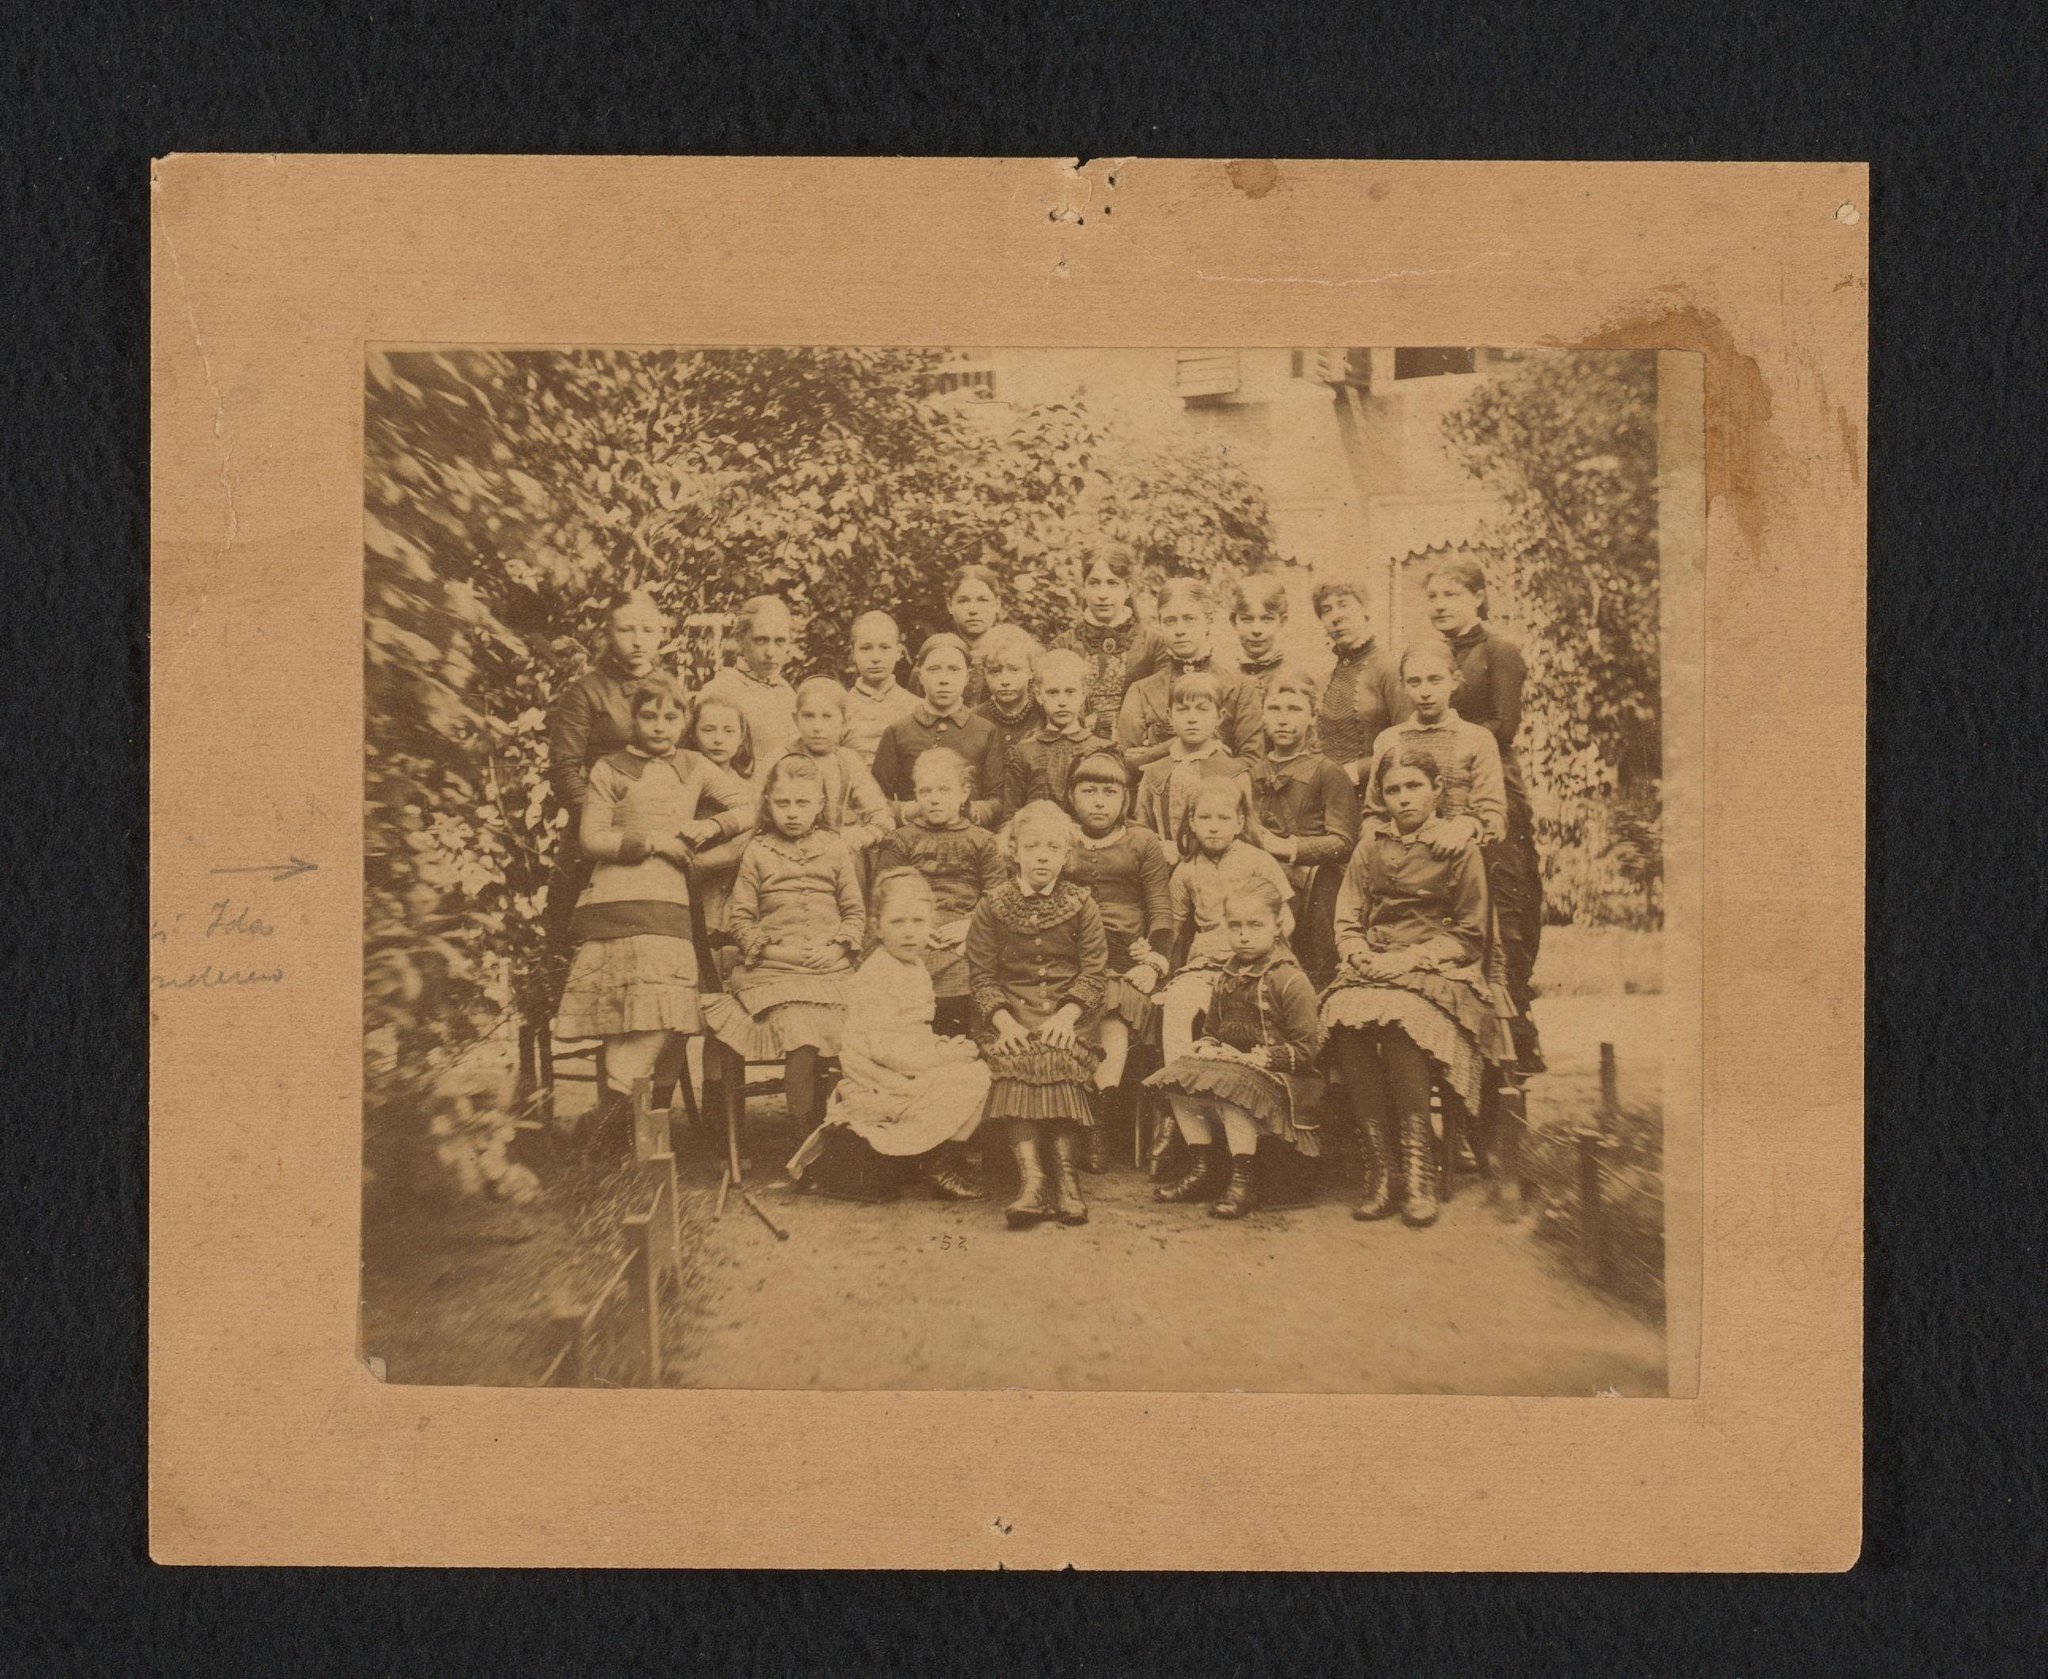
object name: photograph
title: Klassenfoto met Gerarda (Ida) van Tonderen als jong meisje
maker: Anonymous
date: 1880-1885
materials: cardboard, paper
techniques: albumen print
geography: netherlands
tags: haarlem, leiden, historical persons, elementary school; class, form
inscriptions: number: ‘52’, name: ‘[...] Ida/ [...]nderen’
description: Het eerste meisje van links is Gerarda (Ida) van Tonderen, de moeder van Johanna (Hans) de Jong.